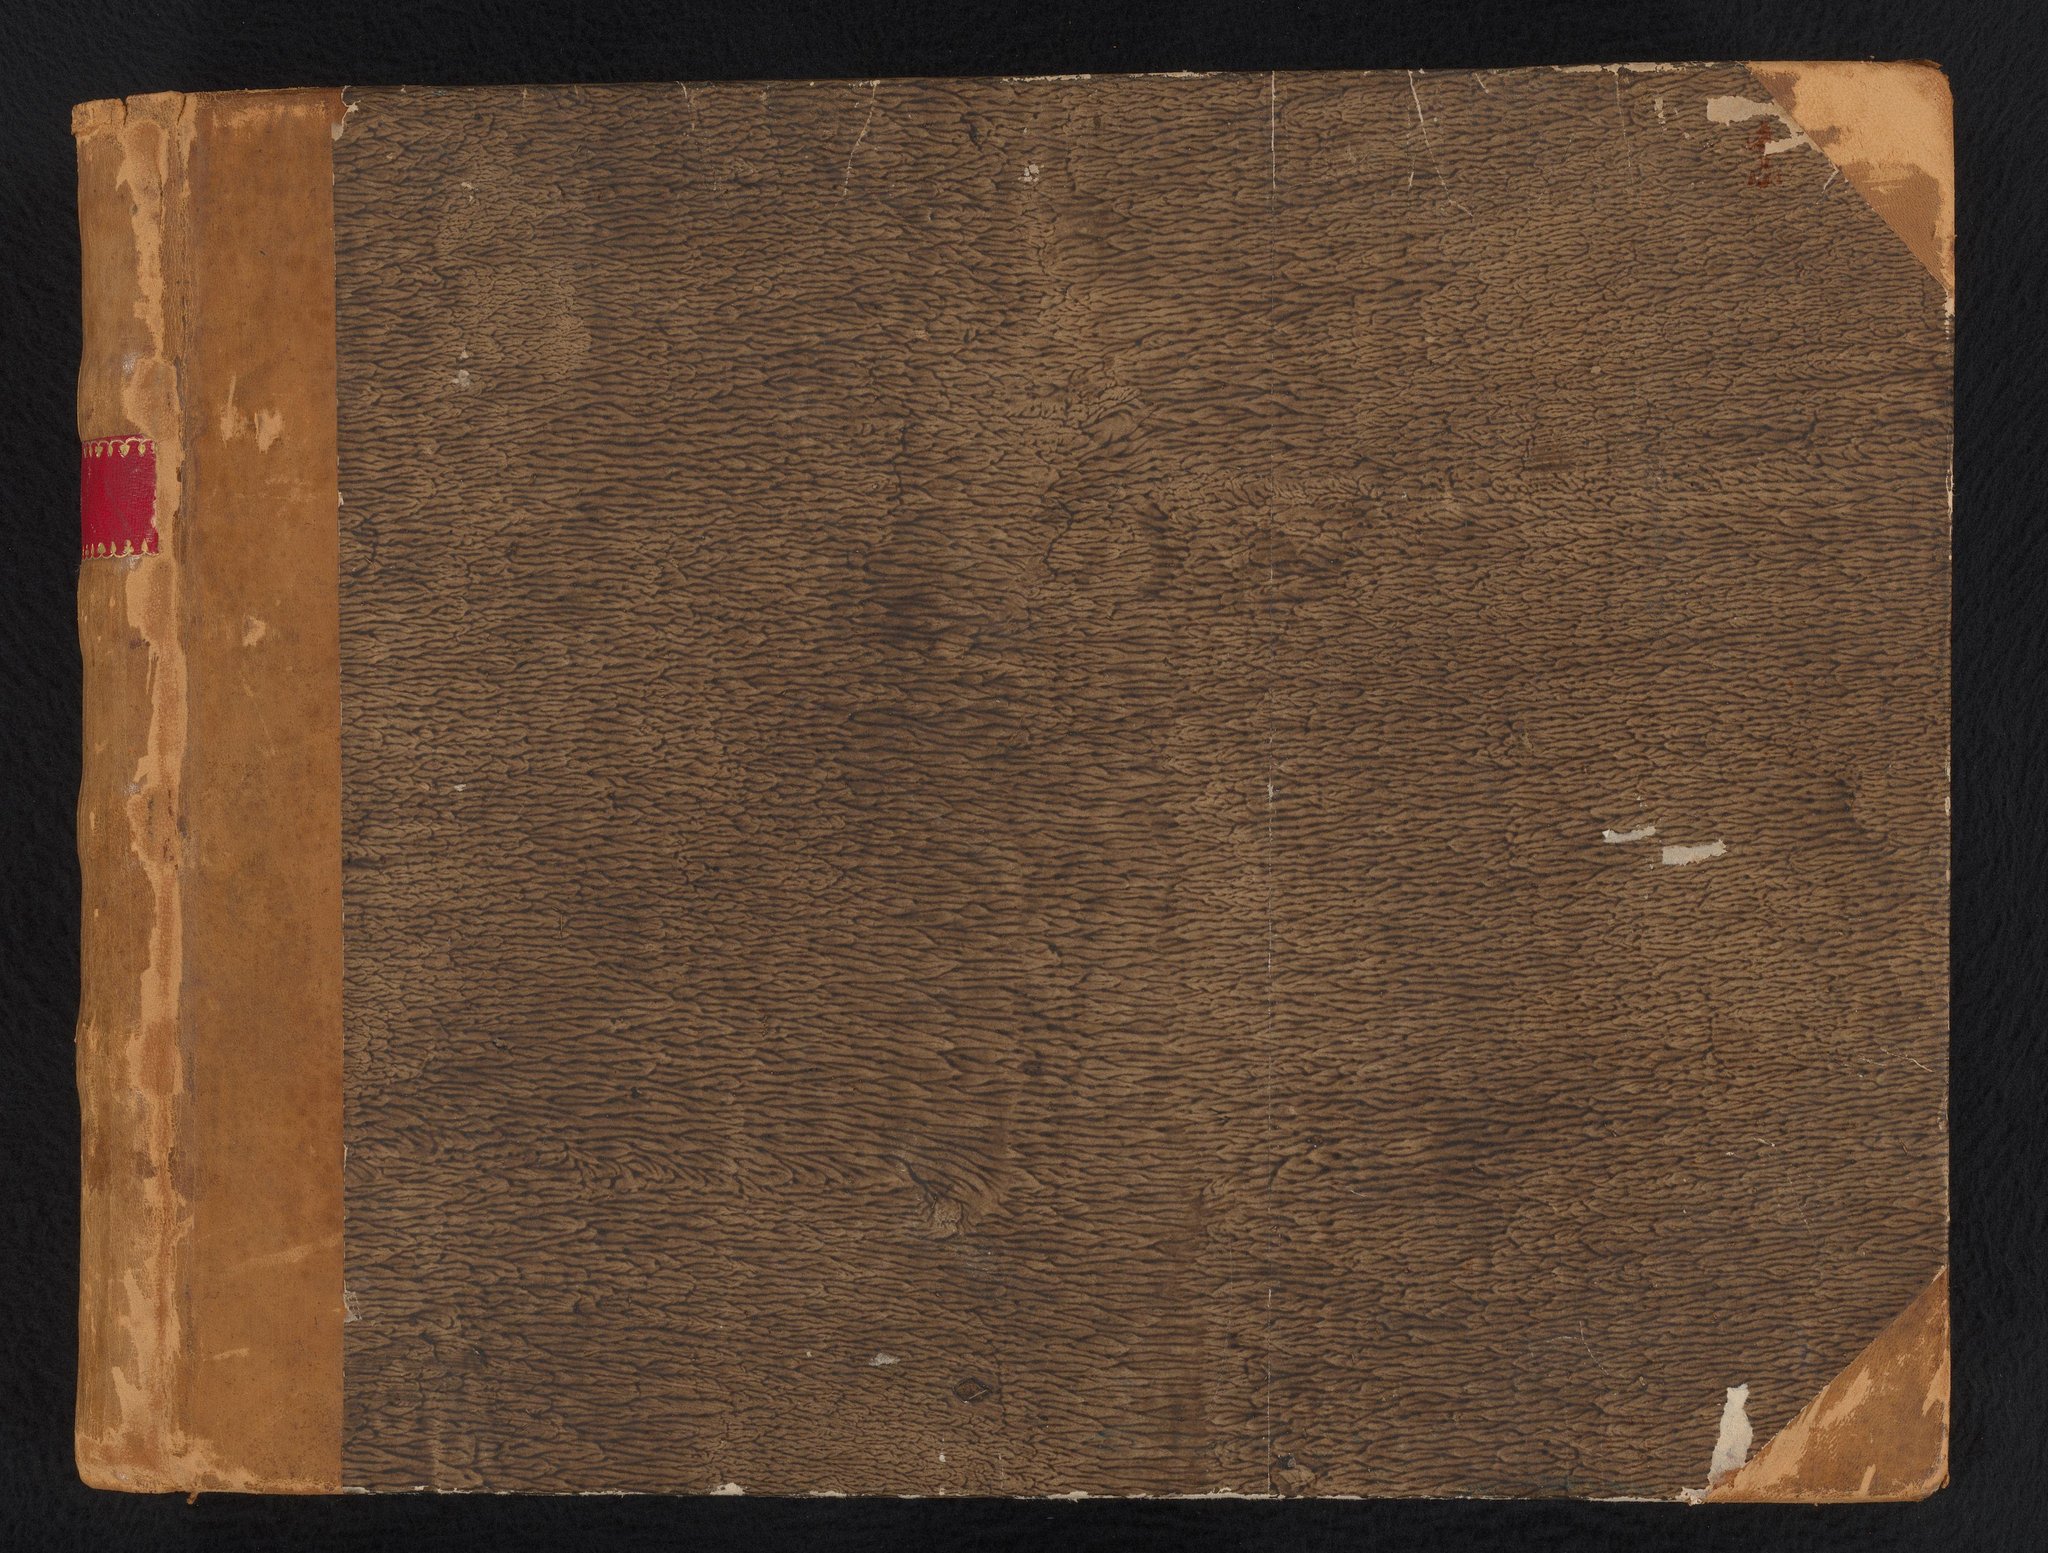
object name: prentrecueil, prentenalbum, prentalbum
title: Columna Antoniniana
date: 1645-1700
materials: cardboard, leather, paper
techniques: bookbinding, engraving, etching, marbling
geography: italy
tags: zuil van marcus aurelius, zuil van trajanus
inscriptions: number: ‘250’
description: Album met 205 prenten op 214 albumbladen. Het album begint met een reeks prenten die de reliëfs van de Zuil van Marcus Aurelius toont. Daarna volgt een reeks prenten die de reliëfs op de Zuil van Trajanus toont. Achterin zit een beschrijving van alle scènes op de Zuil van Trajanus en een index in boekdruk. Een kartonnen band, beplakt met leer en groen marmerpapier, met voor- en achterin een blanco schutblad.